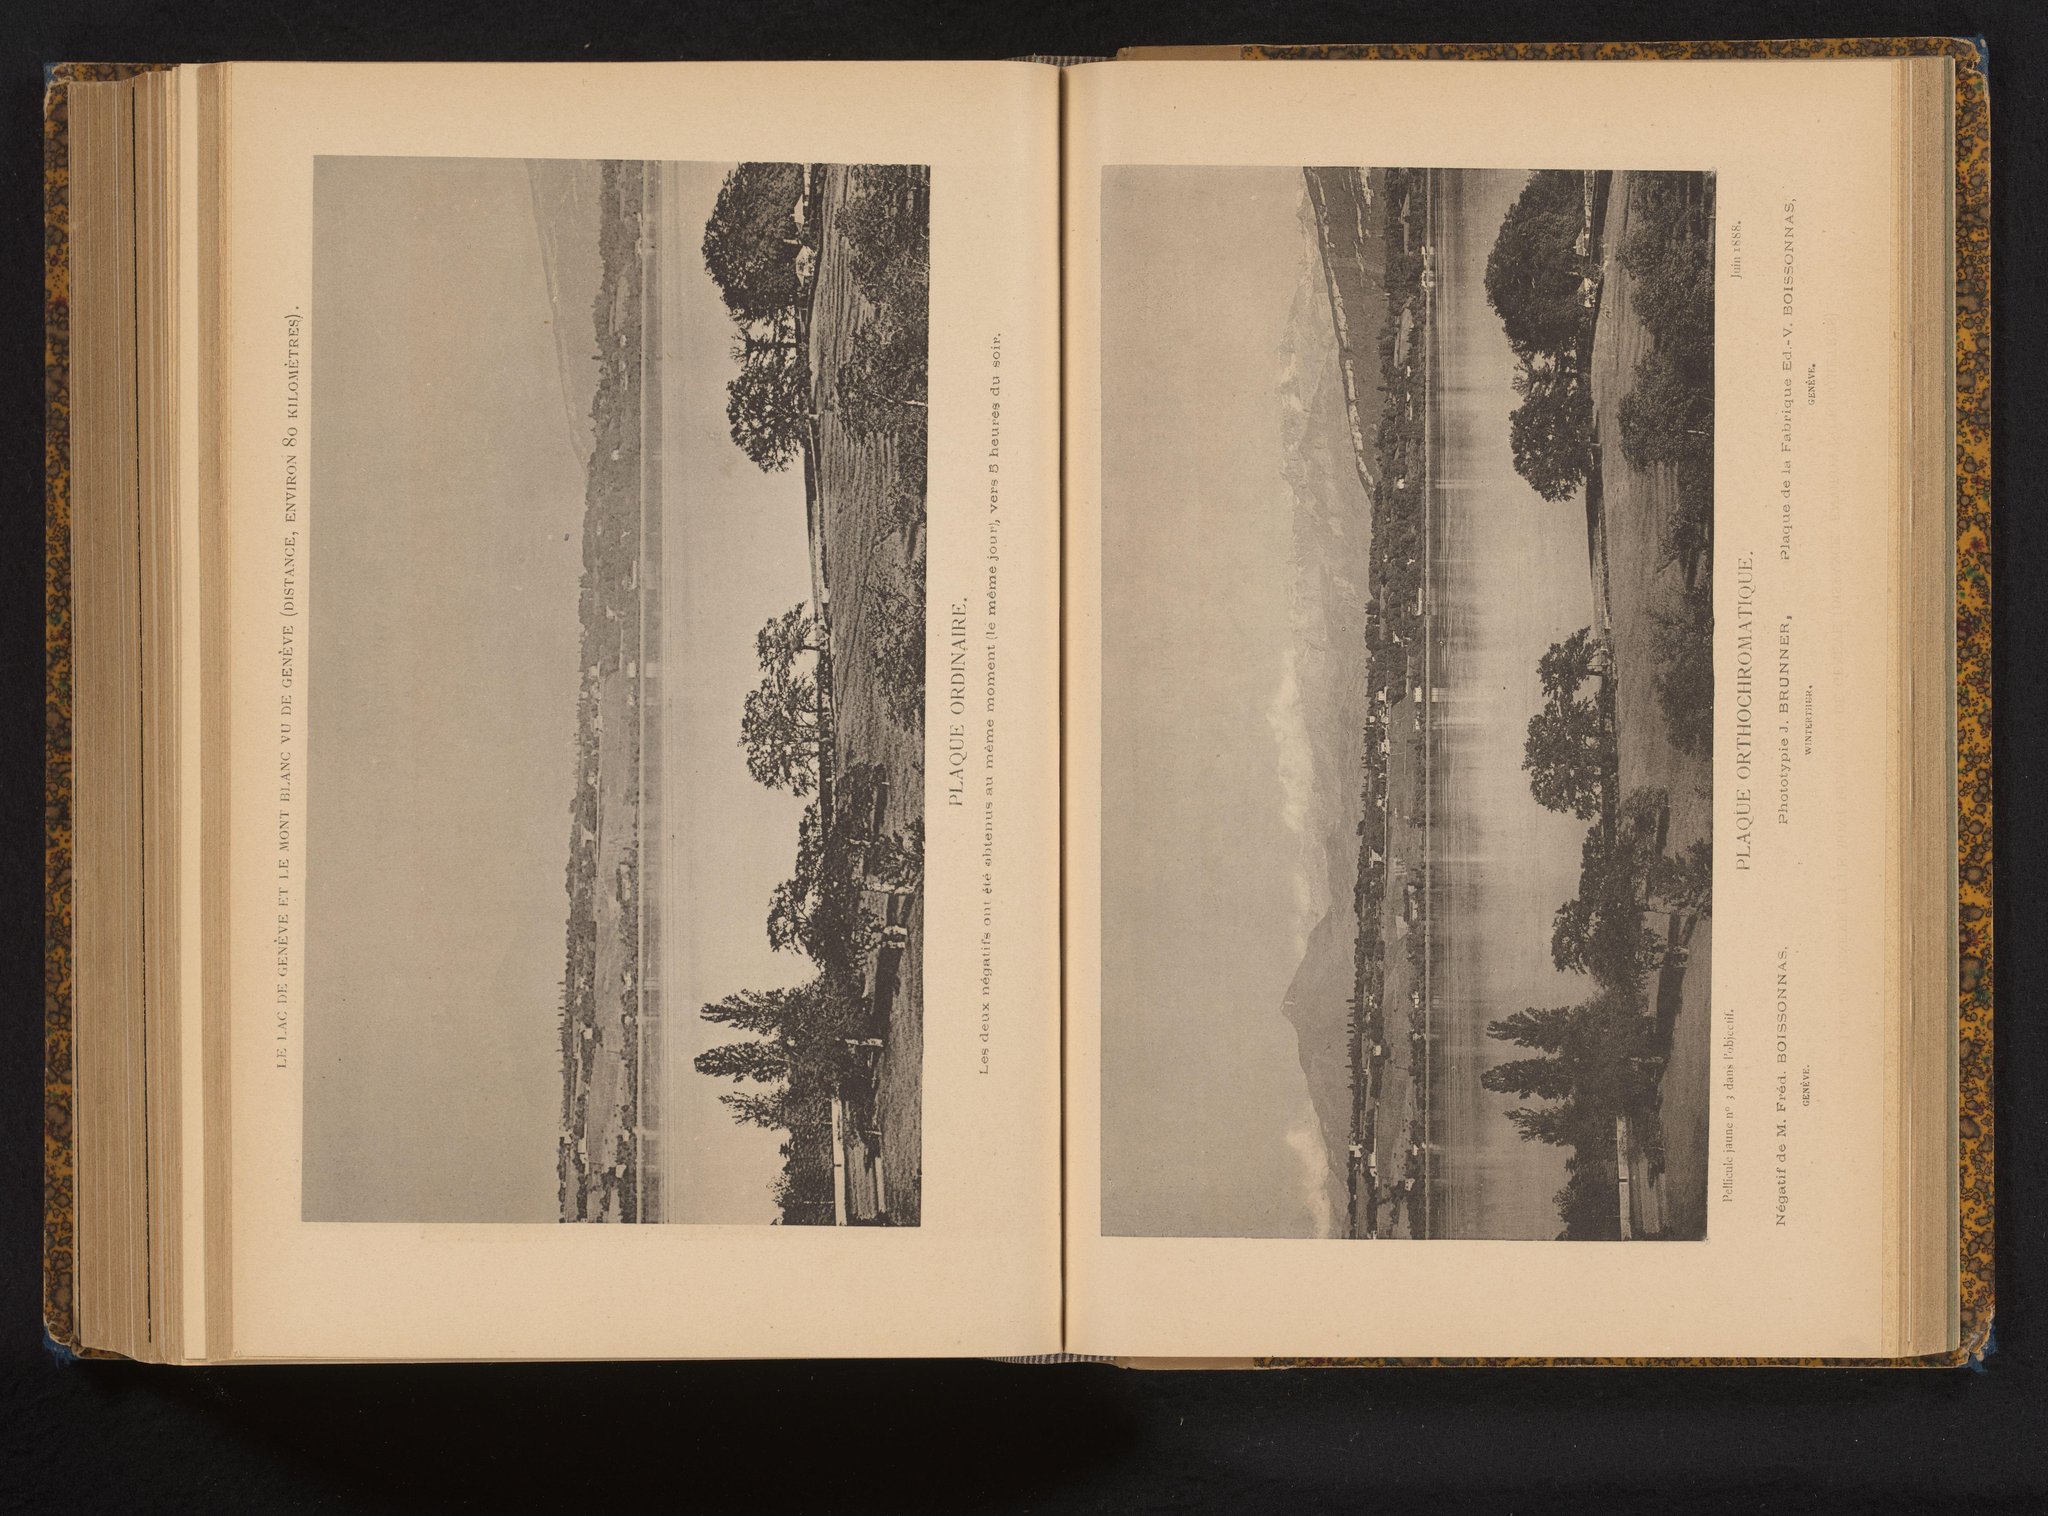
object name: photomechanical print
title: Gezicht op het Meer van Genève en de Mont Blanc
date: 1806-1888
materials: paper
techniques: photograph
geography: dornach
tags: lake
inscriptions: inscription: ‘Plaque ordinarie./ Les deux négatifs ont été obtenus au même moment (le même jour), vers 5 heures du soir.’